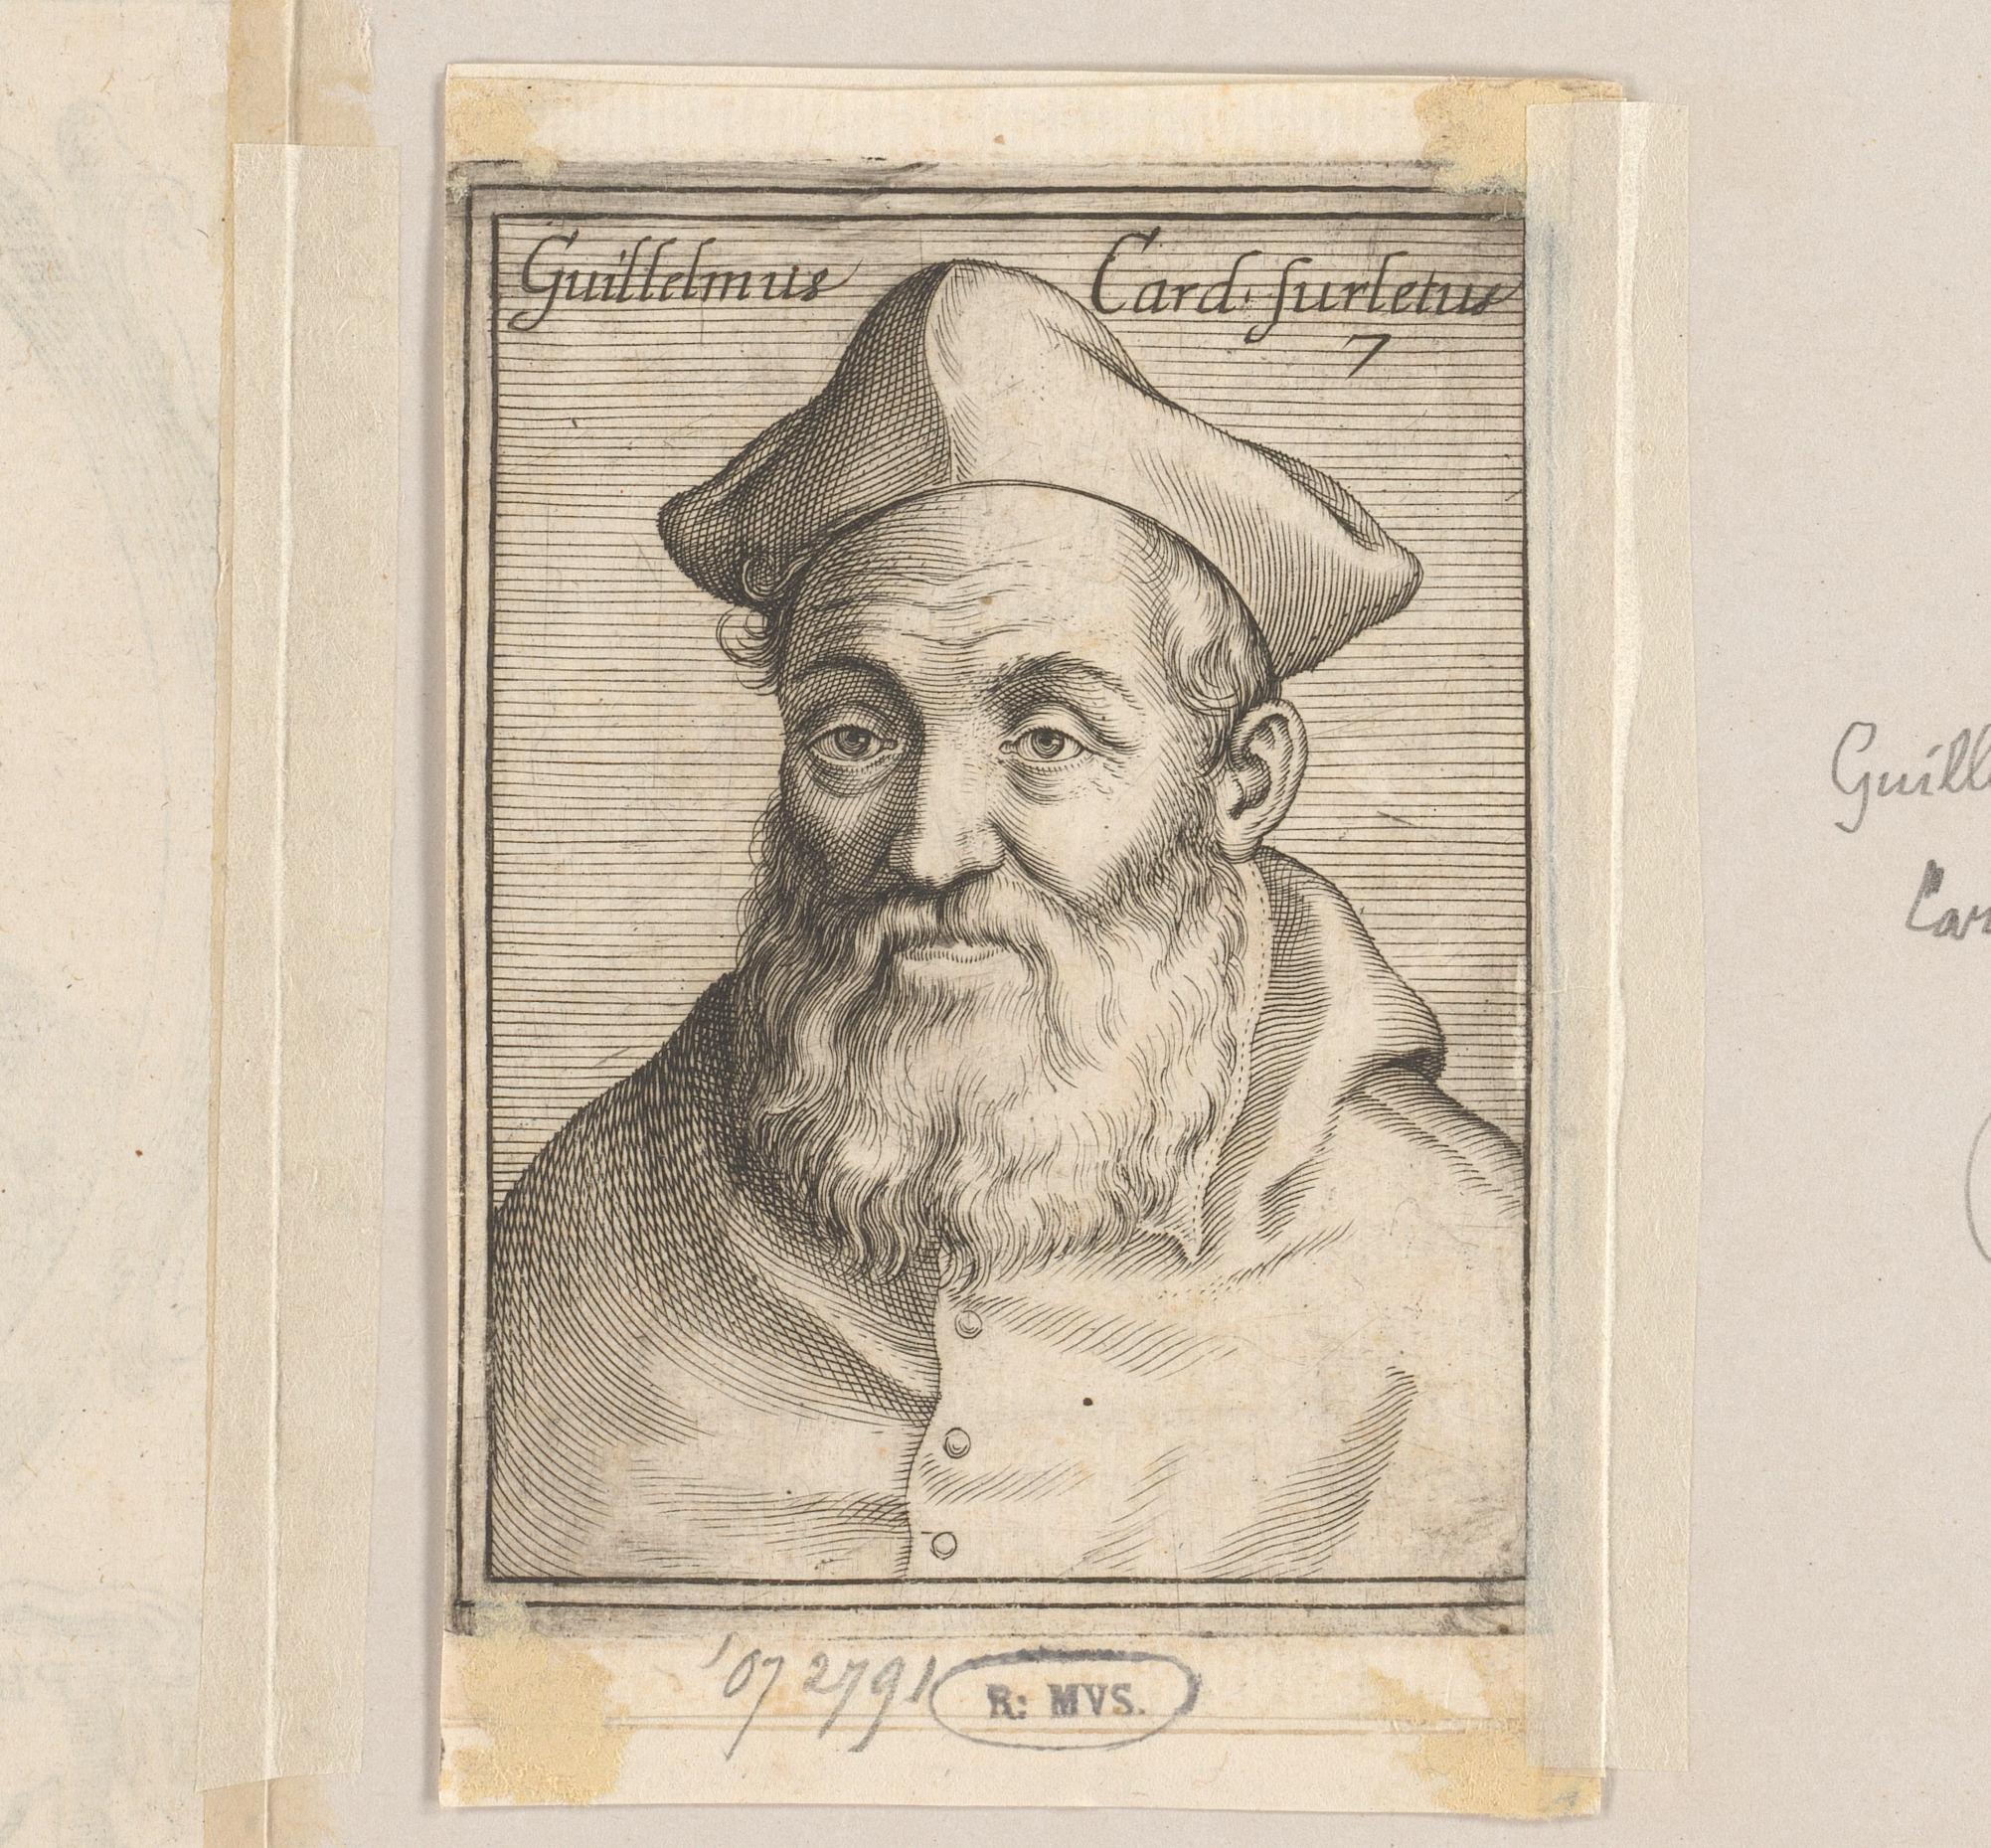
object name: print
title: Ritratti di Uomini Illustri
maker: Anonymous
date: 1625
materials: paper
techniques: engraving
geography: italy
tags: cardinal, adult man, historical persons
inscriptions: collector's mark: Lugt 2228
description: Prent komt uit een serie genummerde portretten, waarvan er veel aanwezig in het British Museum. Bij het BM heet deze serie 'Ritratti di Uomini Illustri'. Prent mogelijk uit: Pernet, Claude. Illustrissimorum, omnique virtutis, et scientiarum laude præstantissimorū virorum icones. S.l.s.n., 1625.